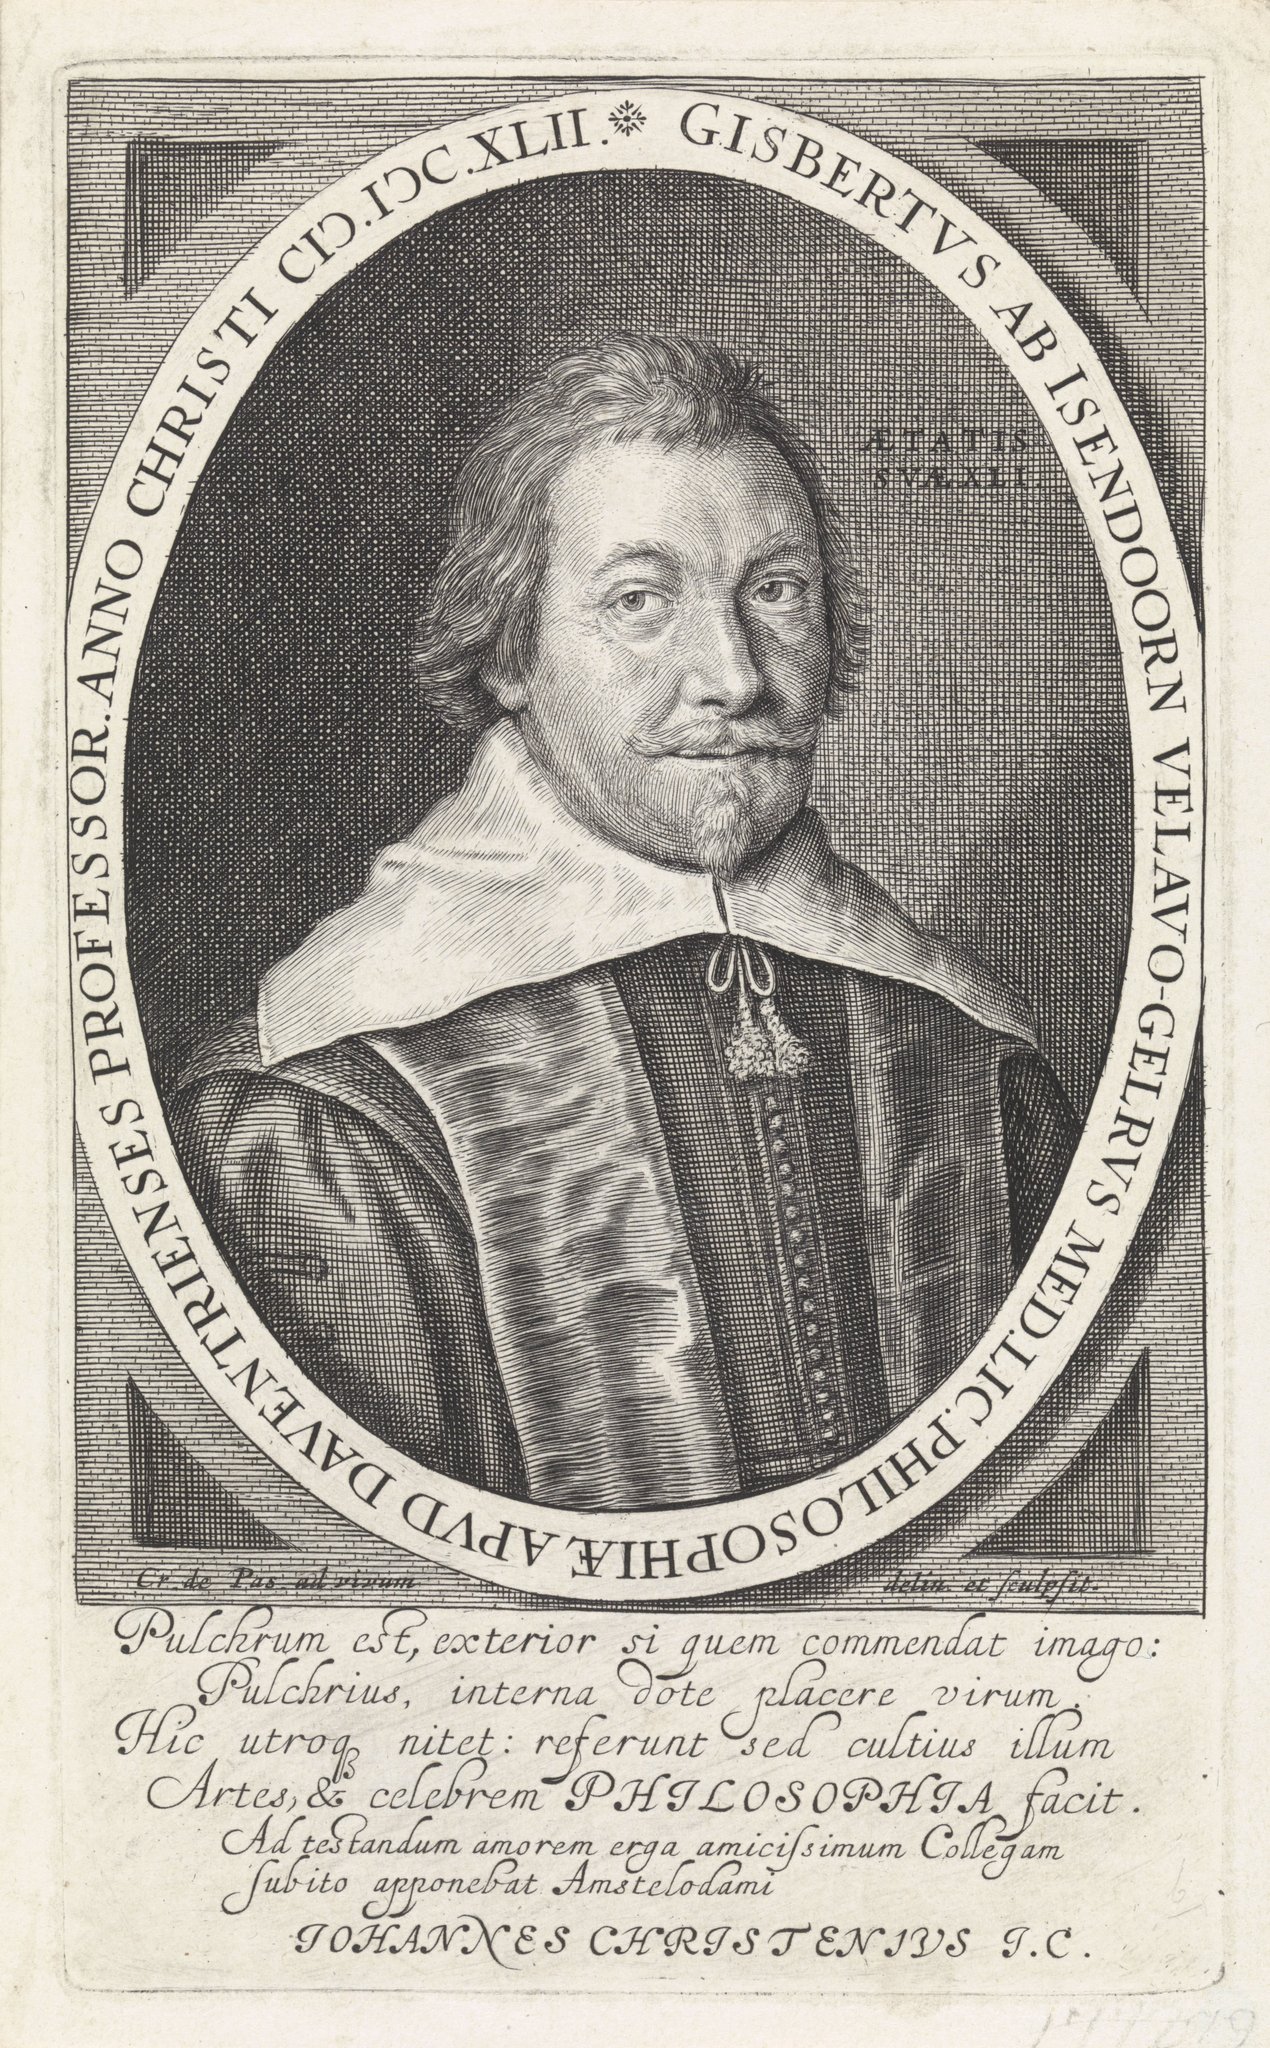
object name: print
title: Portret van Gijsbrecht ab Isendoorn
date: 1642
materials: paper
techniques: engraving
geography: amsterdam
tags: medicus, professor, gijsbrecht ab isendoorn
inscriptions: collector's mark: Lugt 1337, collector's mark: Lugt 2228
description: Portret van de professor Gijsbrecht ab Isendoorn, op 41-jarige leeftijd. In het randschrift van de omlijsting de naam en functie van de geportretteerde in het Latijn. In de marge een zesregelig lofdicht in het Latijn.